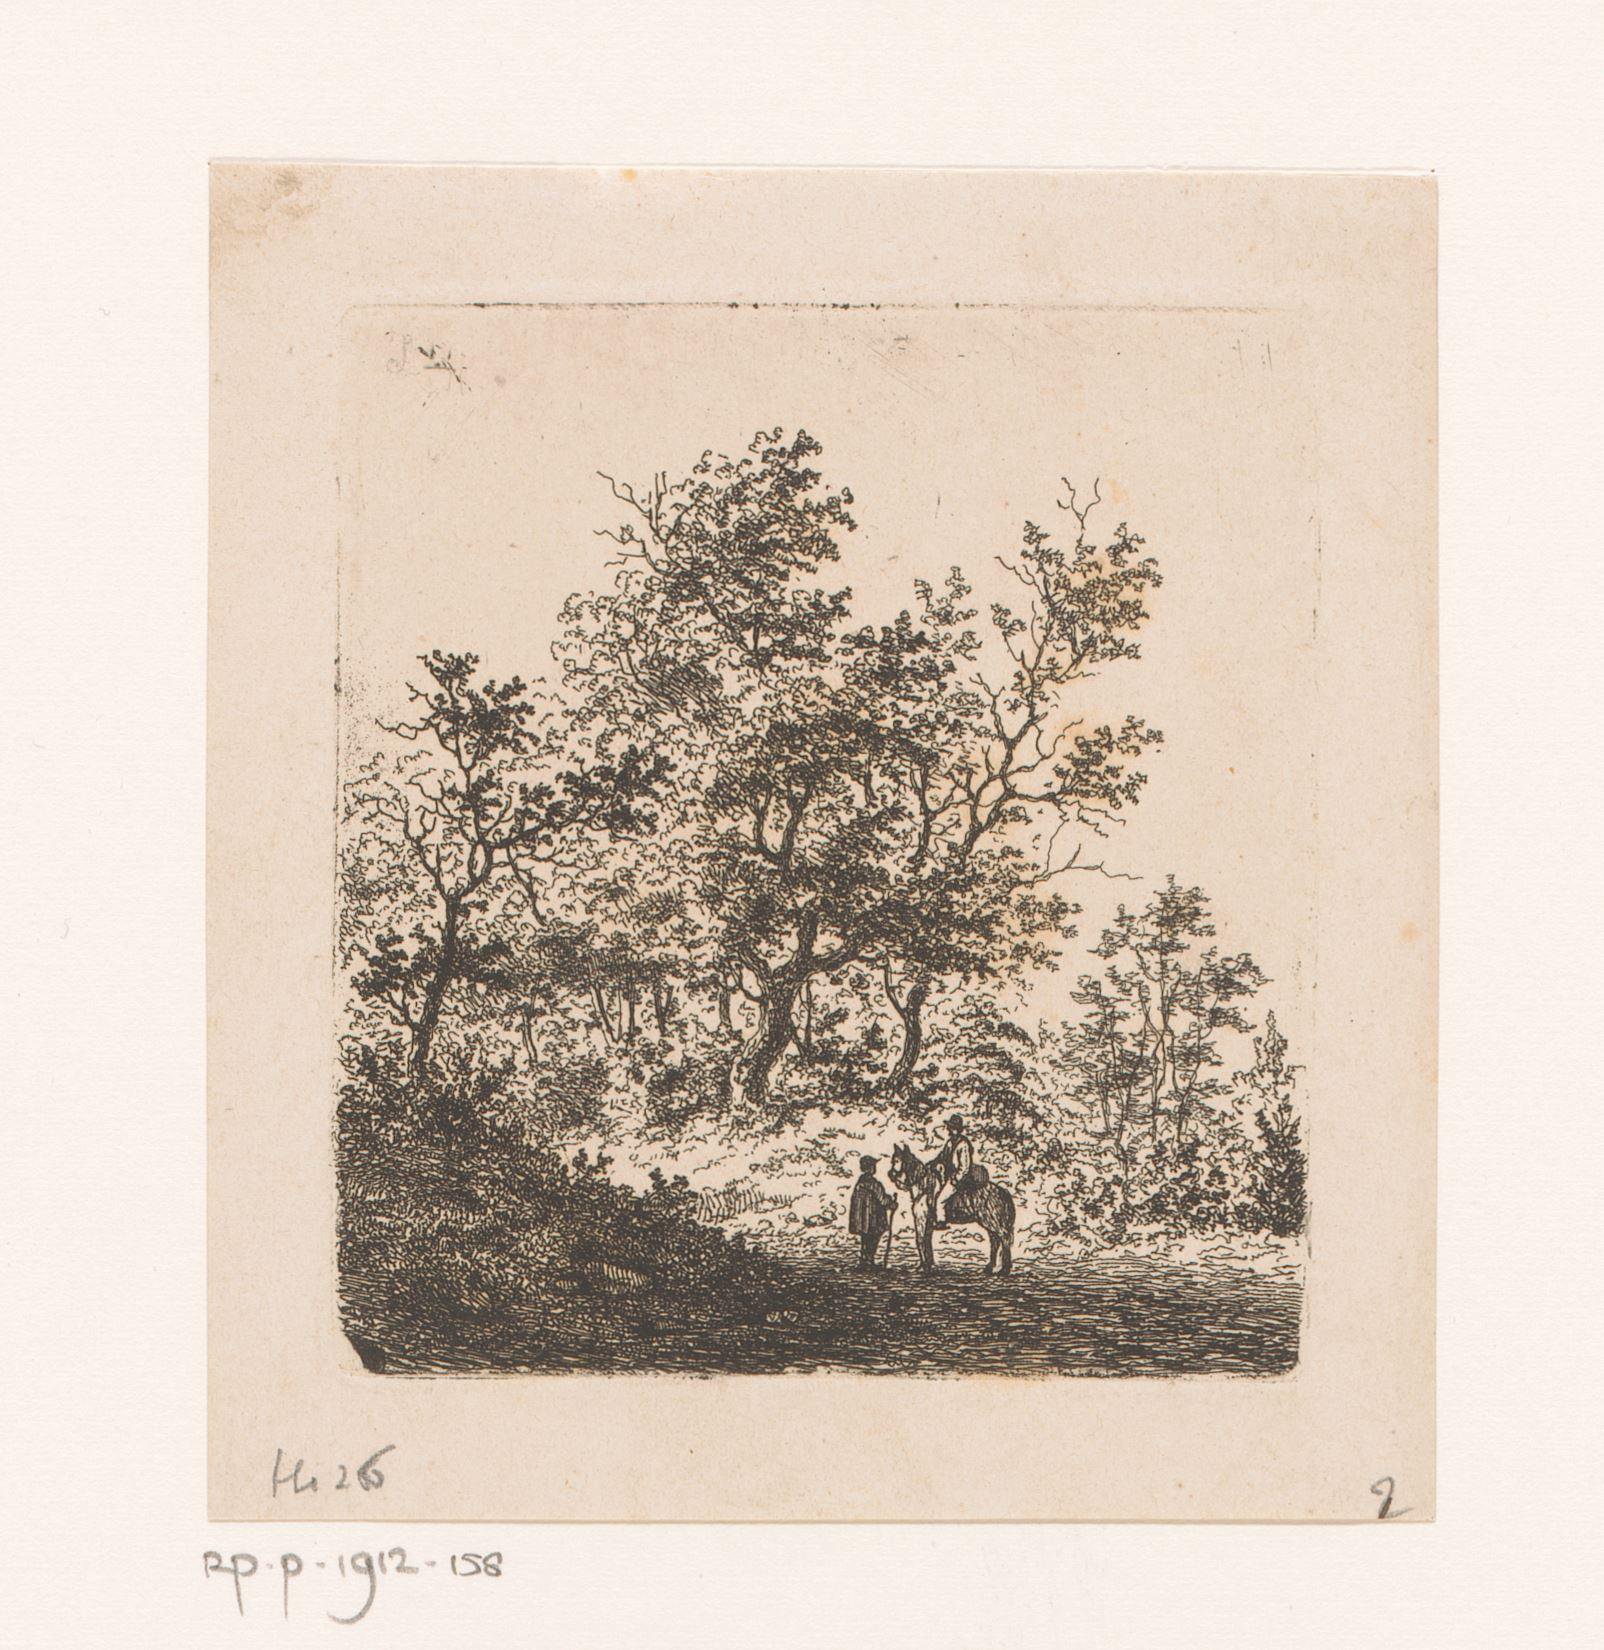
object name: print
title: Boslandschap bij Beert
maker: jean théodore joseph linnig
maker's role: draughtsman, print maker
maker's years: 1815-1891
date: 1848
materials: paper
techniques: etching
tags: forest path or lane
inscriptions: collector's mark: Lugt 1485, collector's mark: Lugt 2228